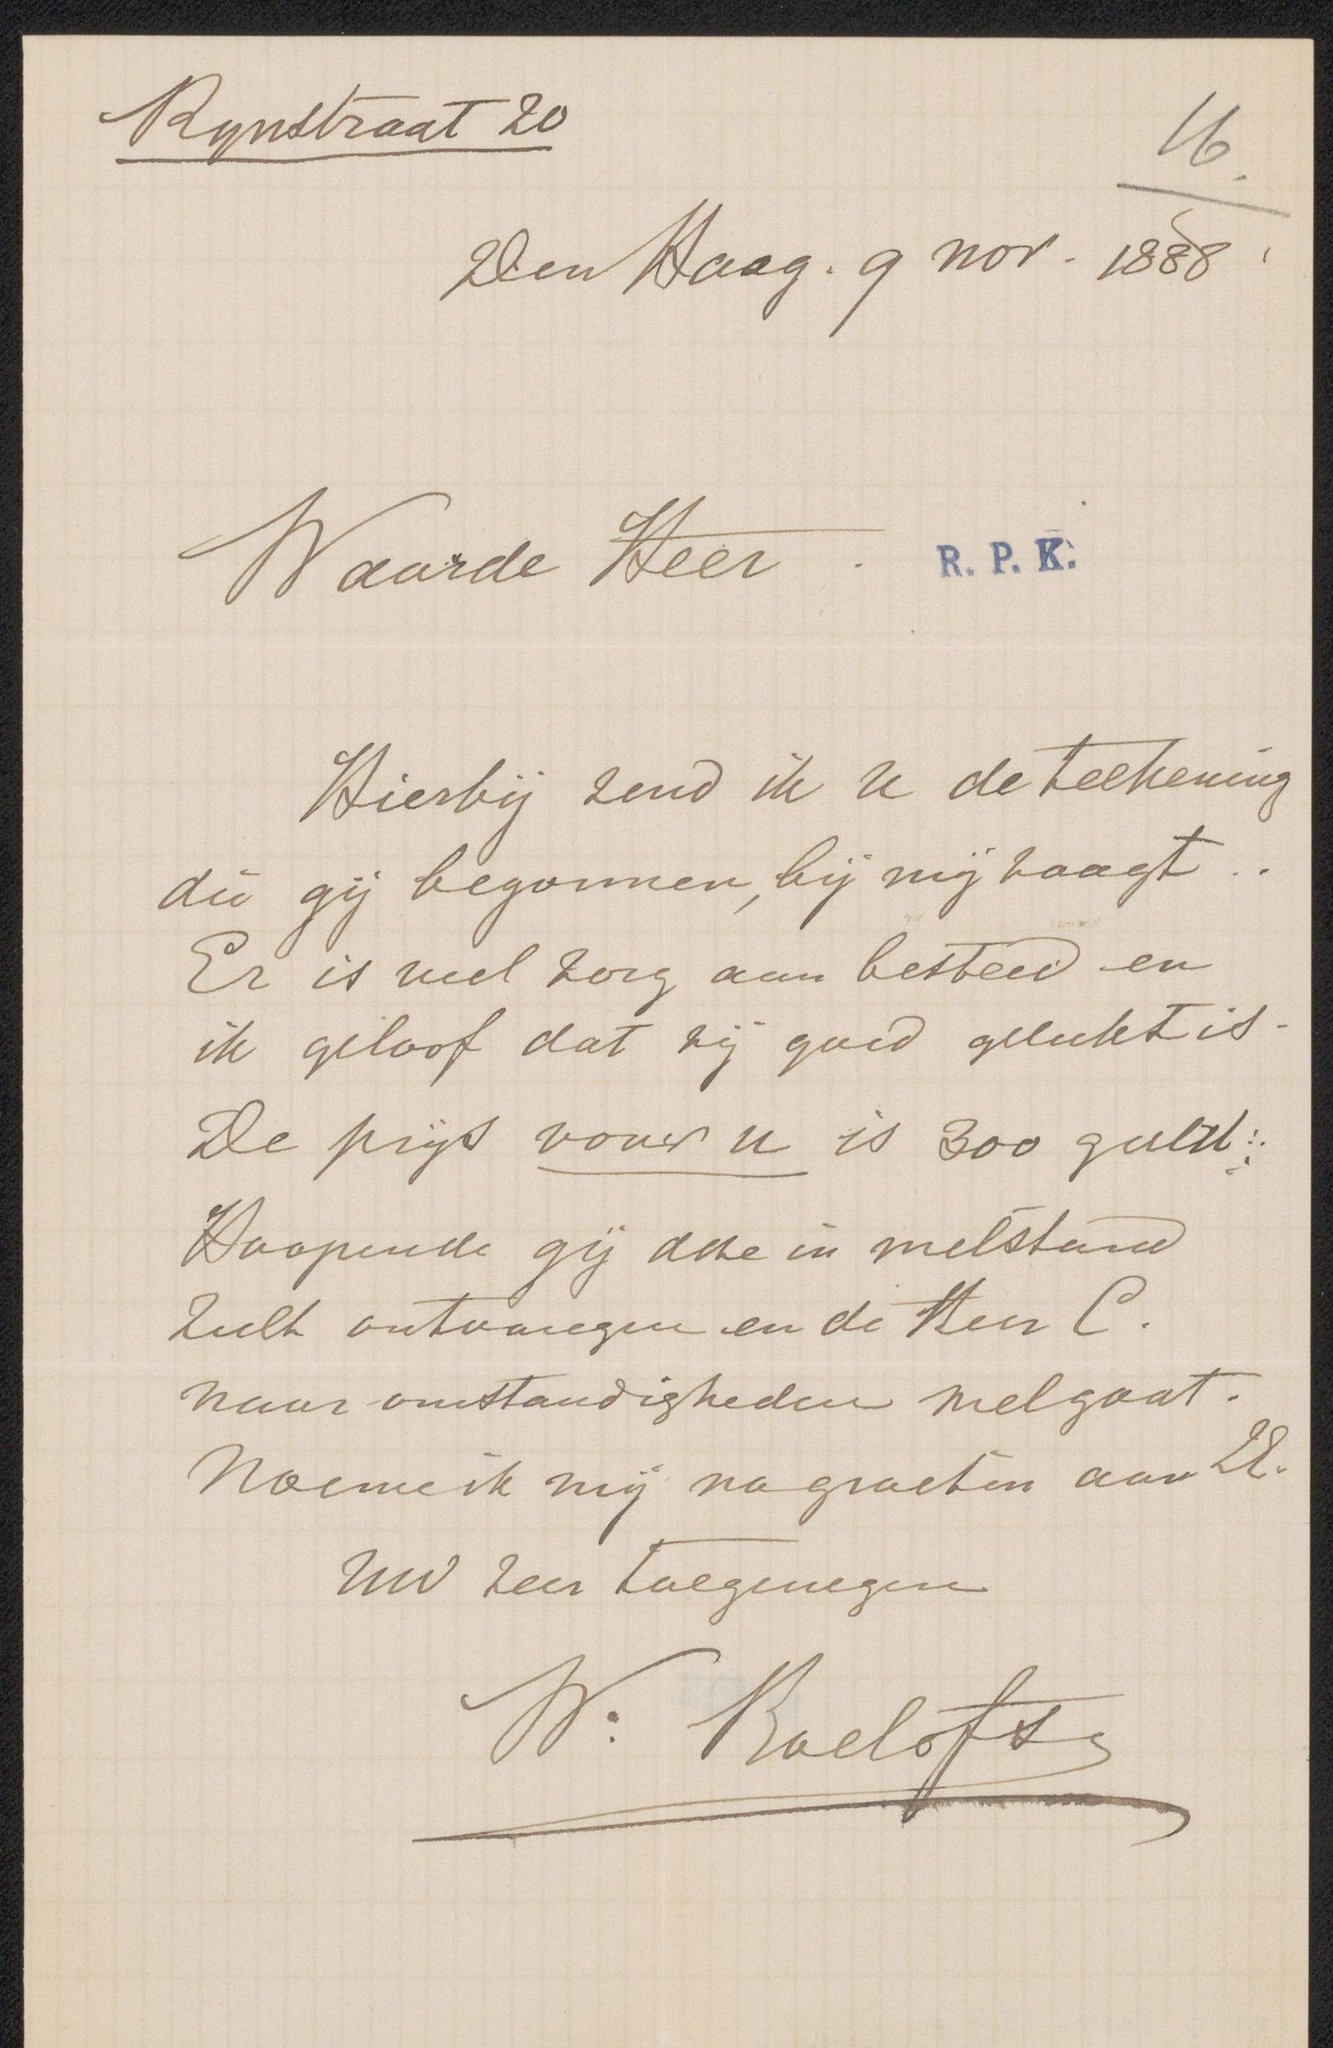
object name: letter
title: Brief aan Frans Buffa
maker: willem roelofs (i)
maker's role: draughtsman, painter, print maker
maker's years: 1822-1897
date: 1888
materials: ink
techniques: pen, writing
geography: the hague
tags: utrecht, amsterdam, publisher, alberto caramelli, printer, frans buffa, art trade, art shop, drawing, money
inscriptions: collector's mark: Lugt 2233